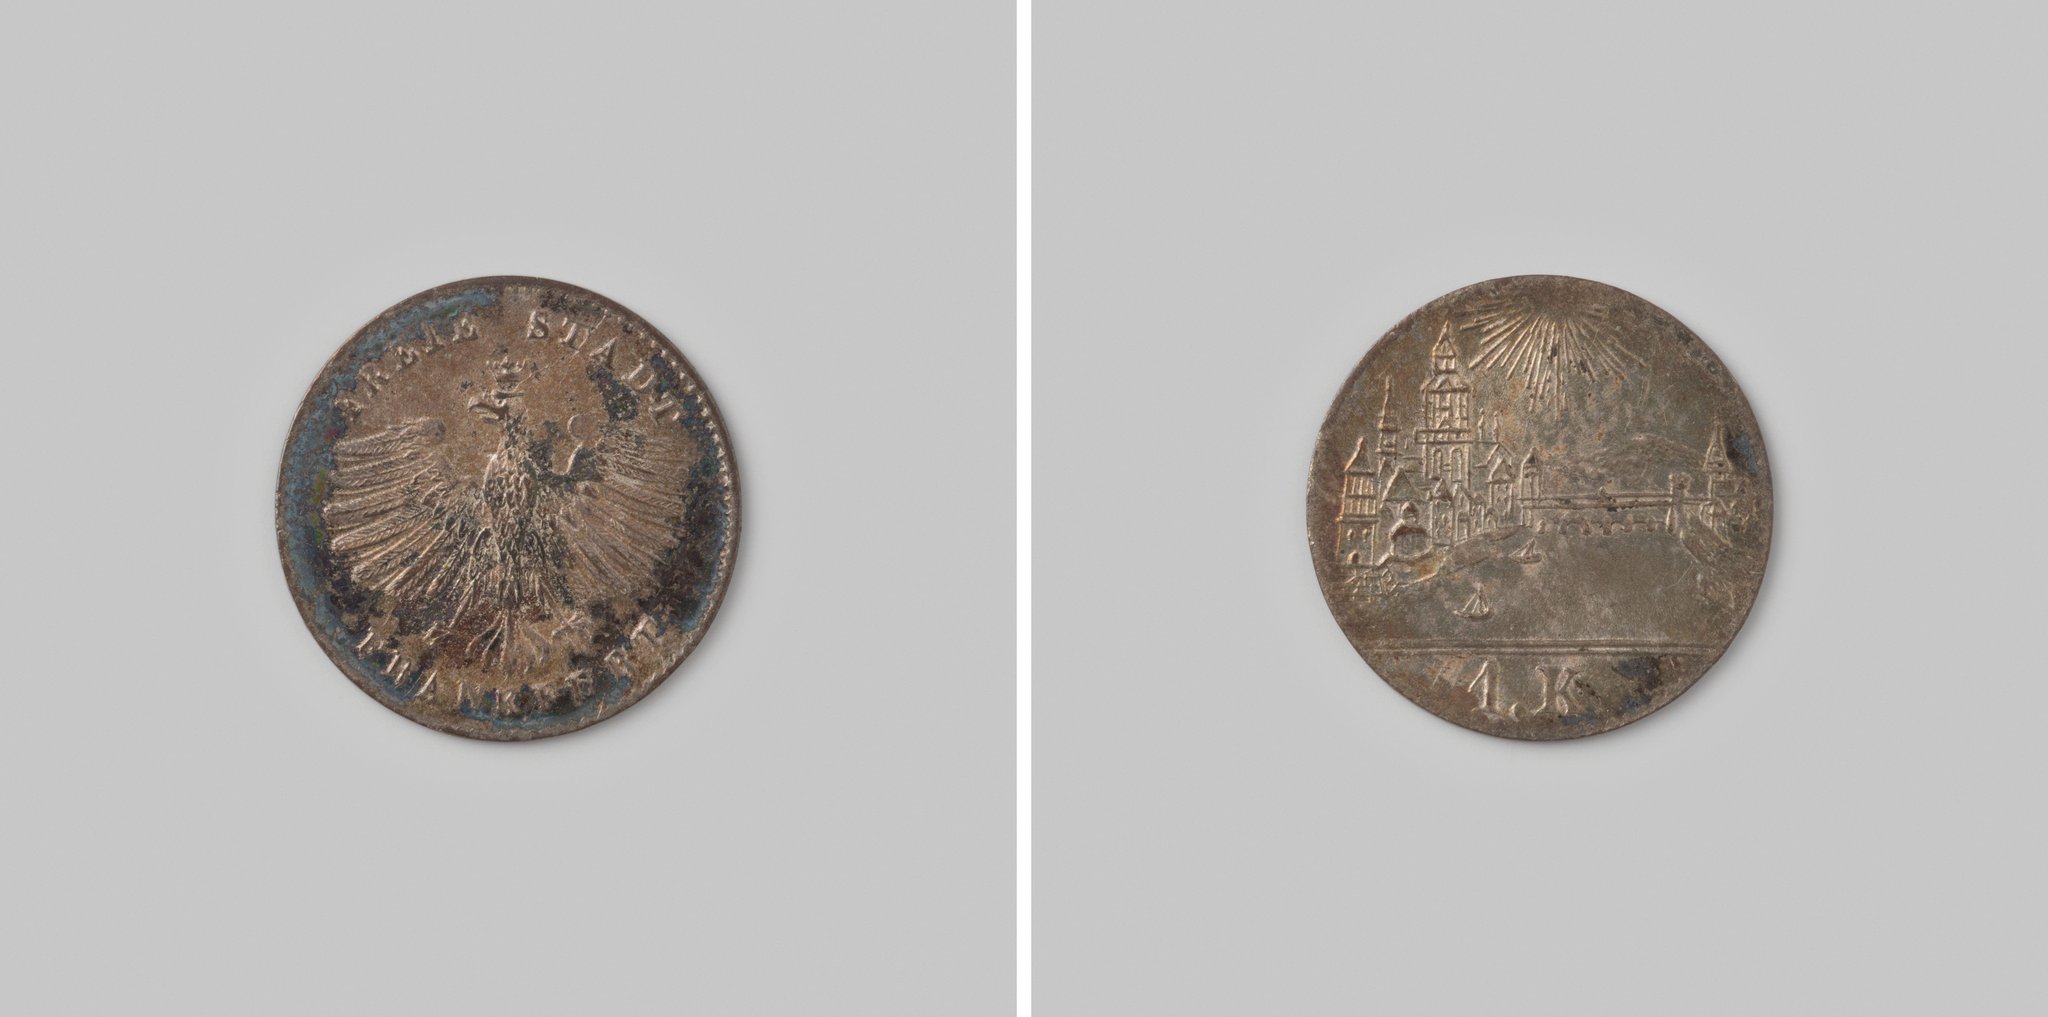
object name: coin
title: Vrije rijksstad Frankfurt am Main, kreuzer, (1839)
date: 1839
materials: silver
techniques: striking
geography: frankfurt am main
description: Zilveren munt. Voorzijde: gekroonde enkekoppige adelaar. Keerzijde: door zonnestralen beschenen stadsgezicht met in afsnede waarde-aanduiding 1. K.. Gladde rand.